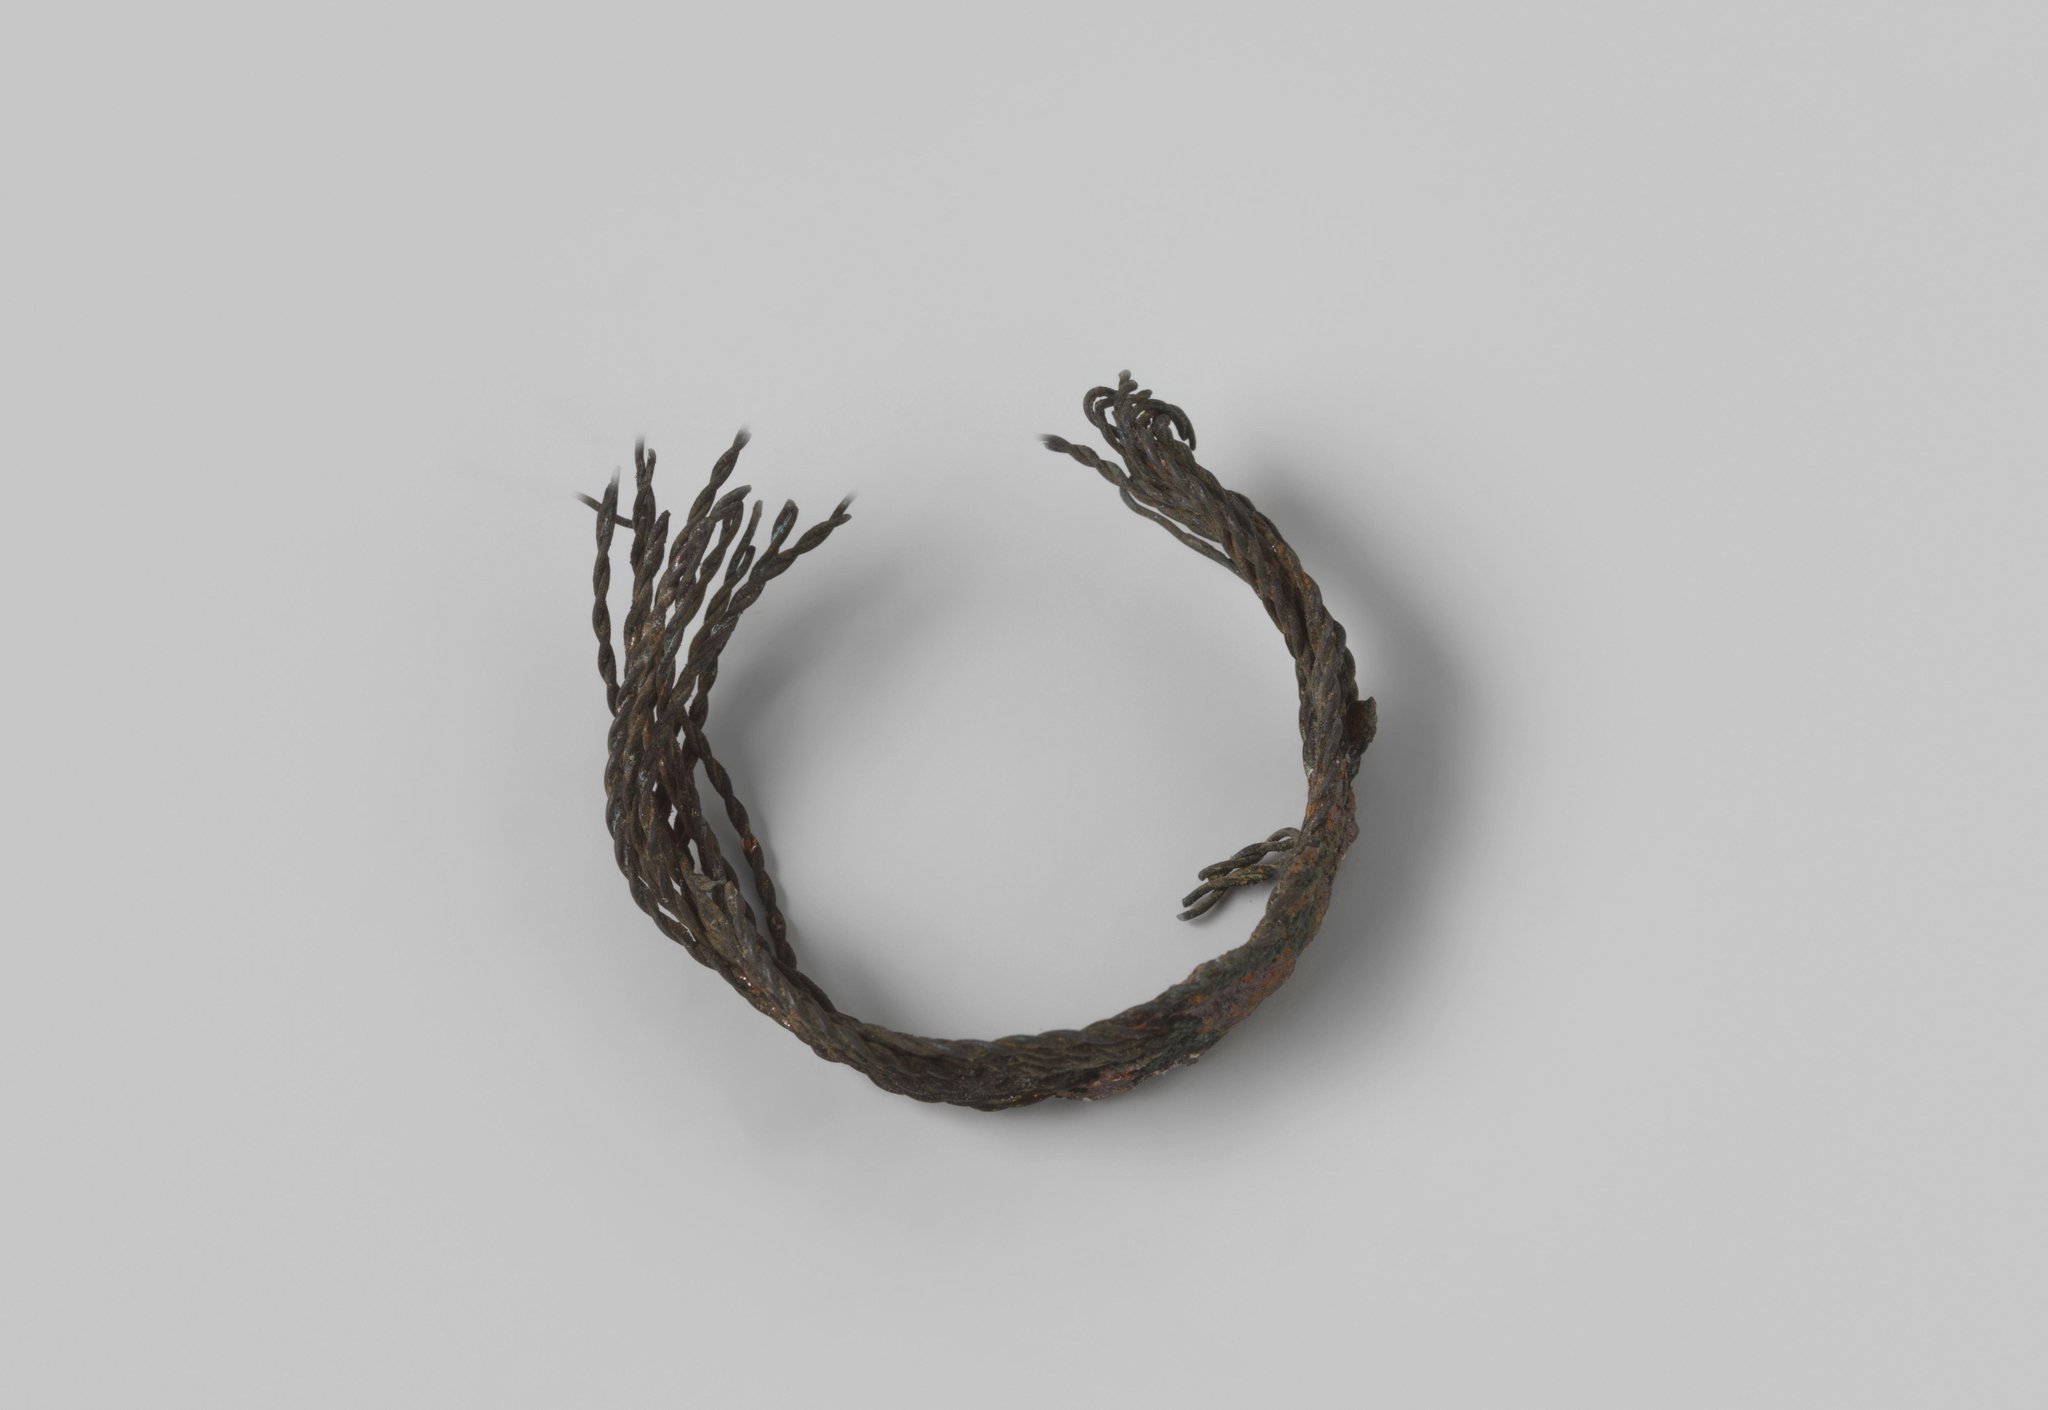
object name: ferrule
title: Beslagring van de greep van een gevest uit het wrak van de Oost-Indiëvaarder Hollandia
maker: Anonymous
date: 1700-1743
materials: copper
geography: netherlands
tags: verenigde oostindische compagnie, hollandia (schip), annet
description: Hilt, grip, ferrule; id. NG 1980-27H2582.